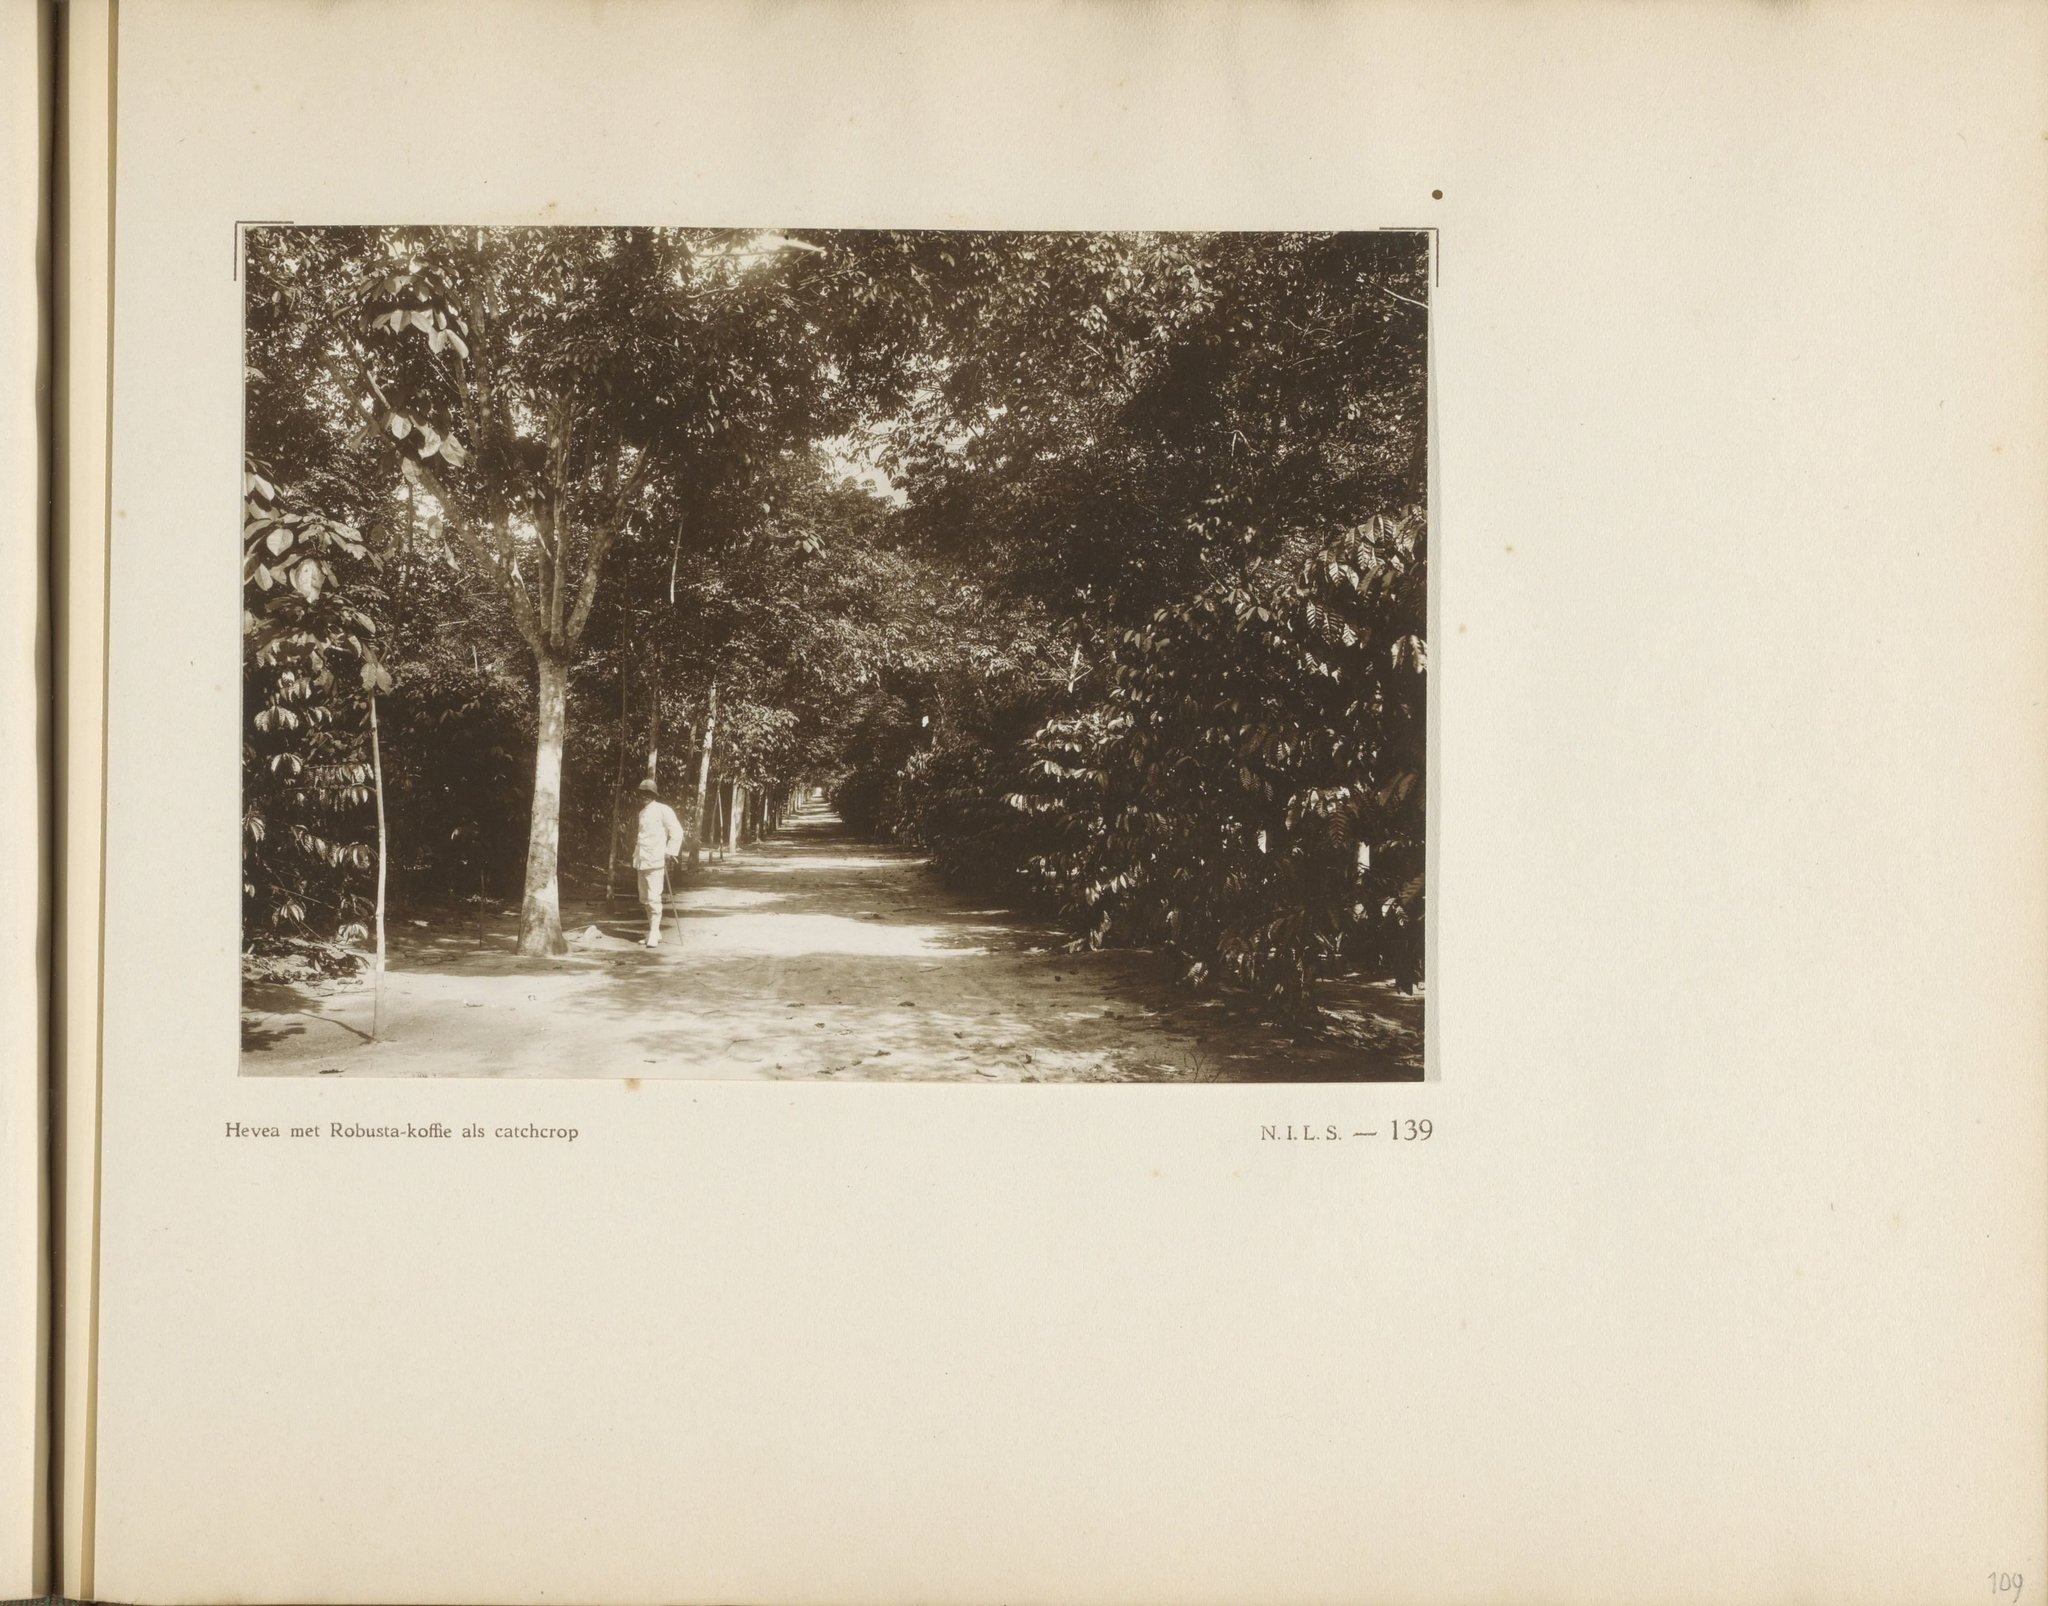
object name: photograph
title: Pagina 139 van fotoboek van de Algemeene Vereeniging van Rubberplanters ter Oostkust van Sumatra (A.V.R.O.S.)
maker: j.w. meyster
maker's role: fotograaf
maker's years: 1887-1945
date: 1924-1925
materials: paper, photographic support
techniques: printing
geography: sumatra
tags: field filled with a crop, coffee, (non-fruit) products of plants or trees: rubber, sumatra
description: Boekpagina met een foto van gemengde rubber- en koffieaanplant op Sumatra (Nederlandsch-Indisch Land Syndicaat). Onderdeel van een fotoboek van de Algemeene Vereeniging van Rubberplanters ter Oostkust van Sumatra (A.V.R.O.S.).